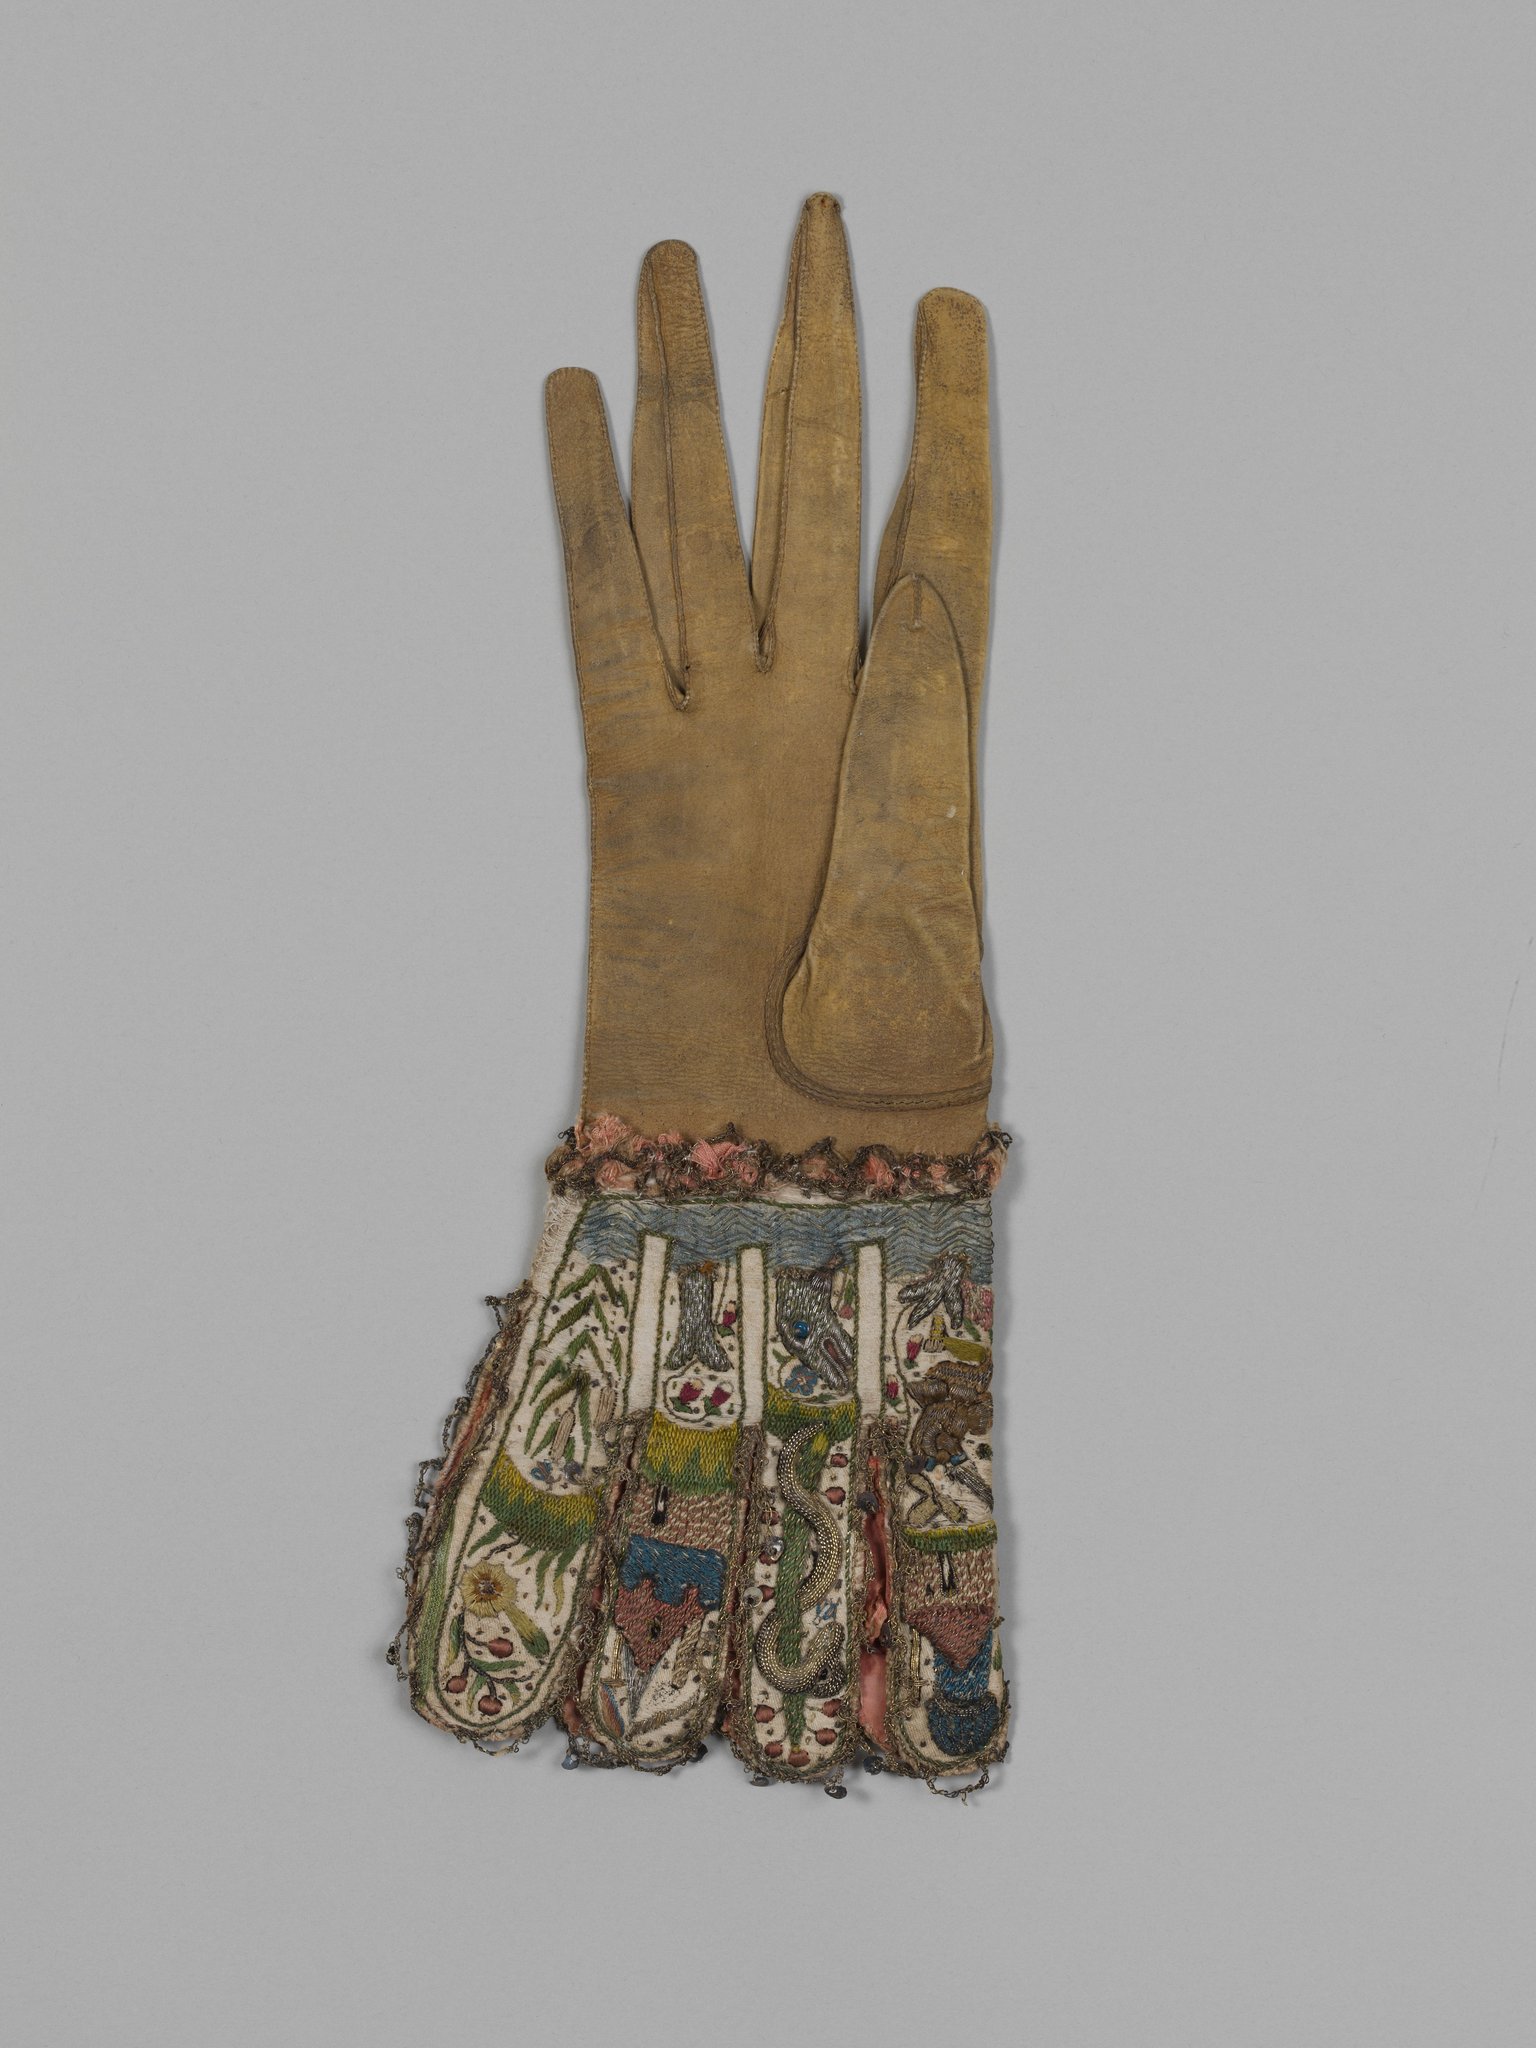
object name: glove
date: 1600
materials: textile, lace, leather, metal thread, silk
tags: snakes